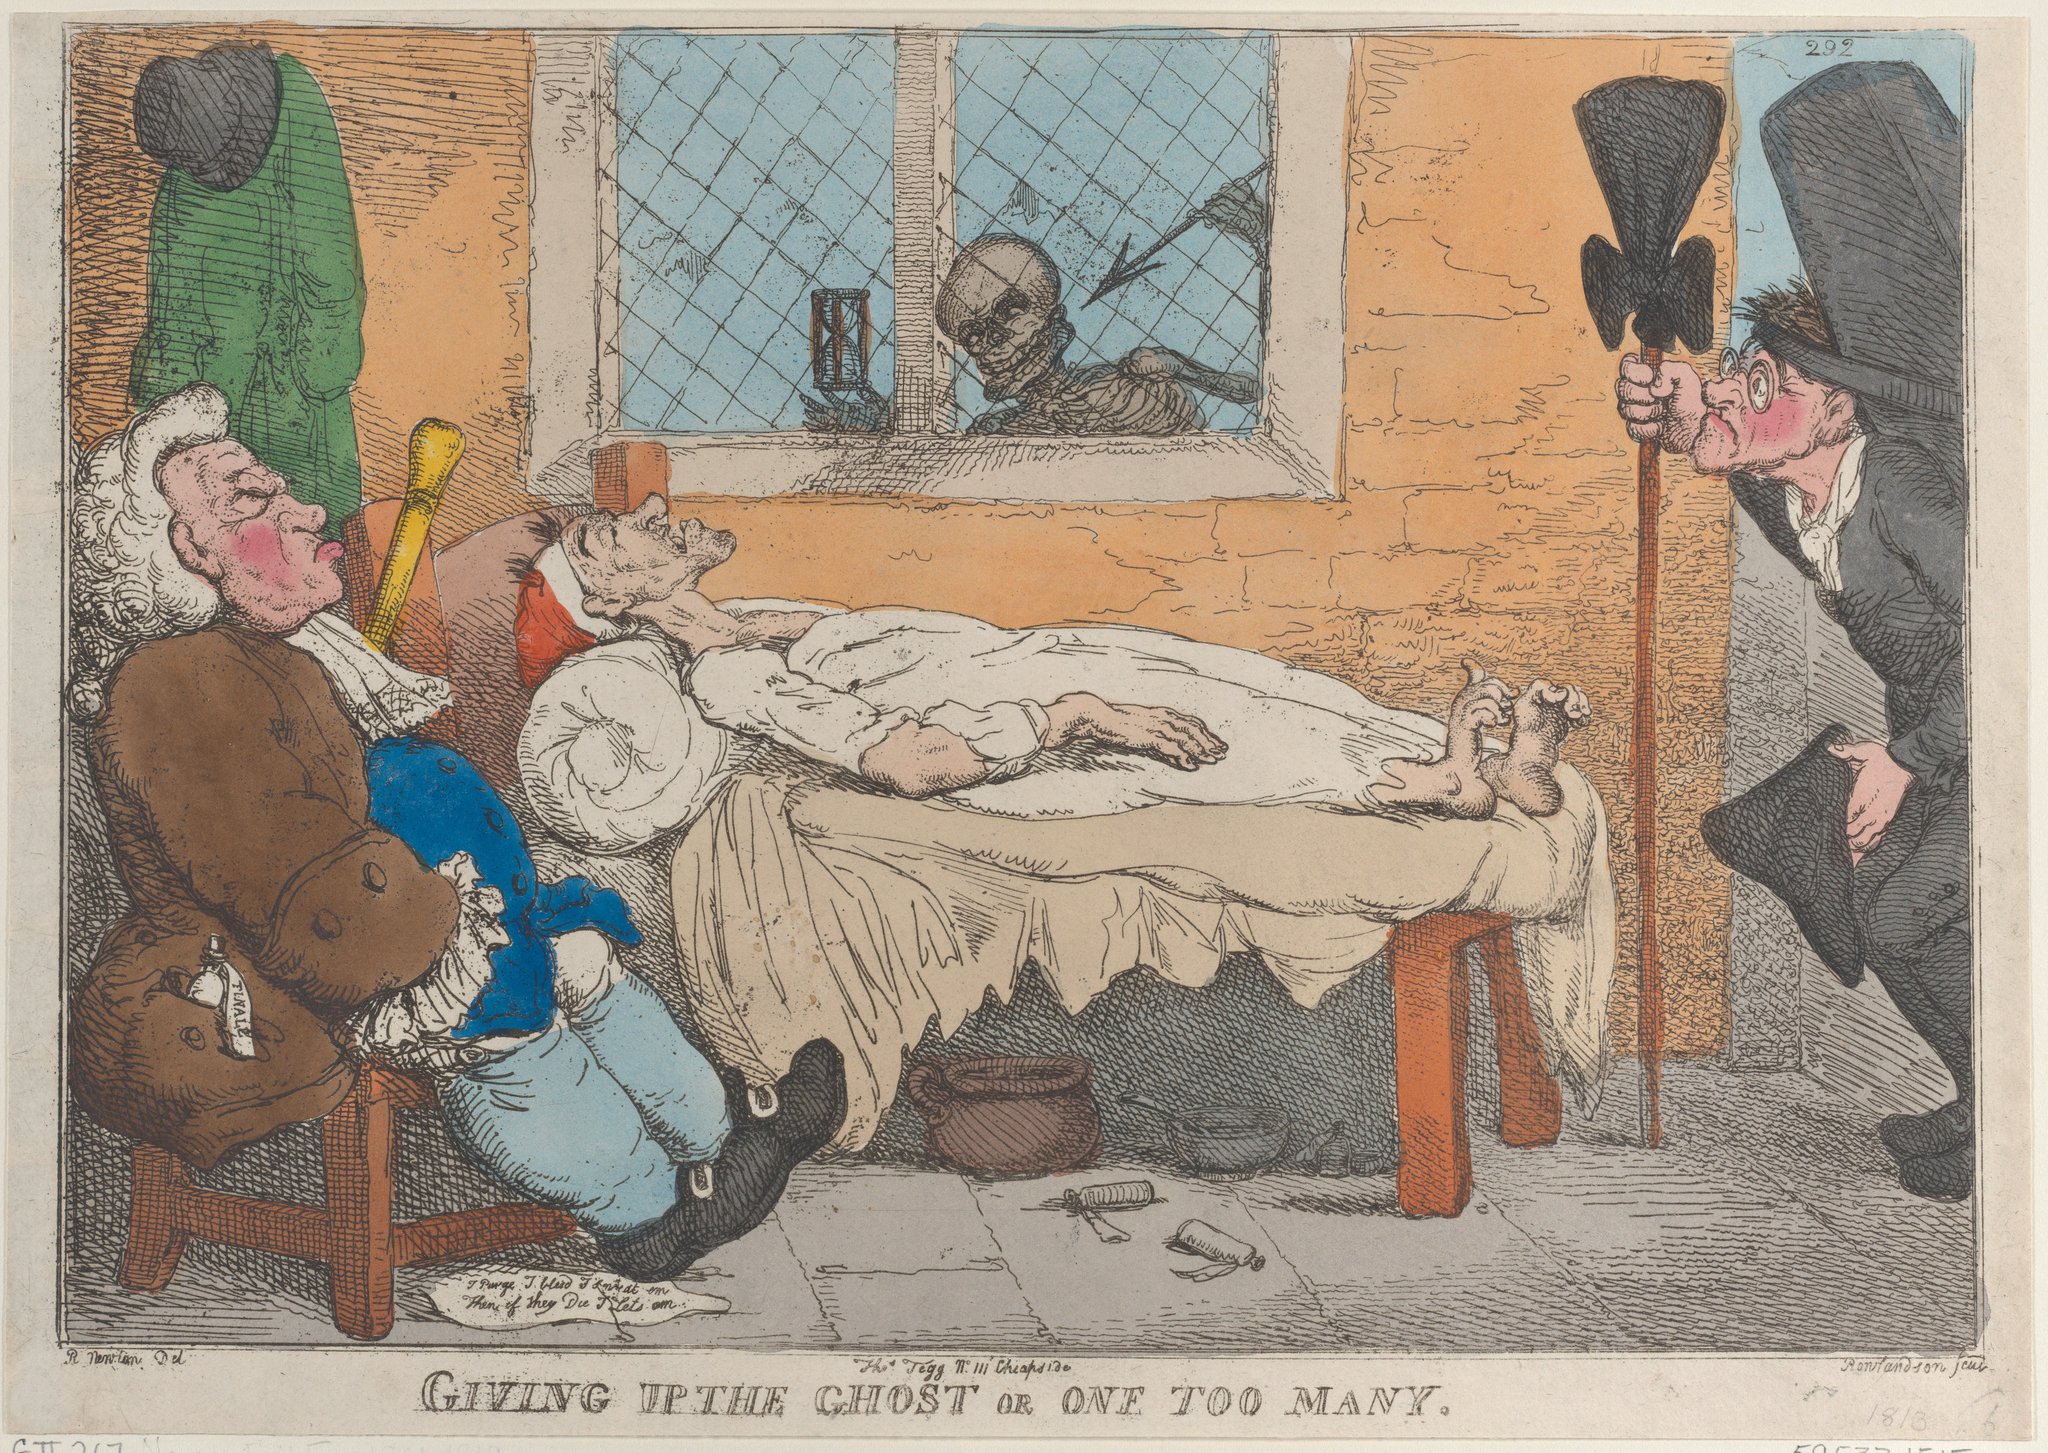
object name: print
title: Giving Up the Ghost or One Too Many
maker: thomas rowlandson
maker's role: artist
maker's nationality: british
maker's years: 1757-1827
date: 1813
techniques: etching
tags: satire,skeletons,men,beds